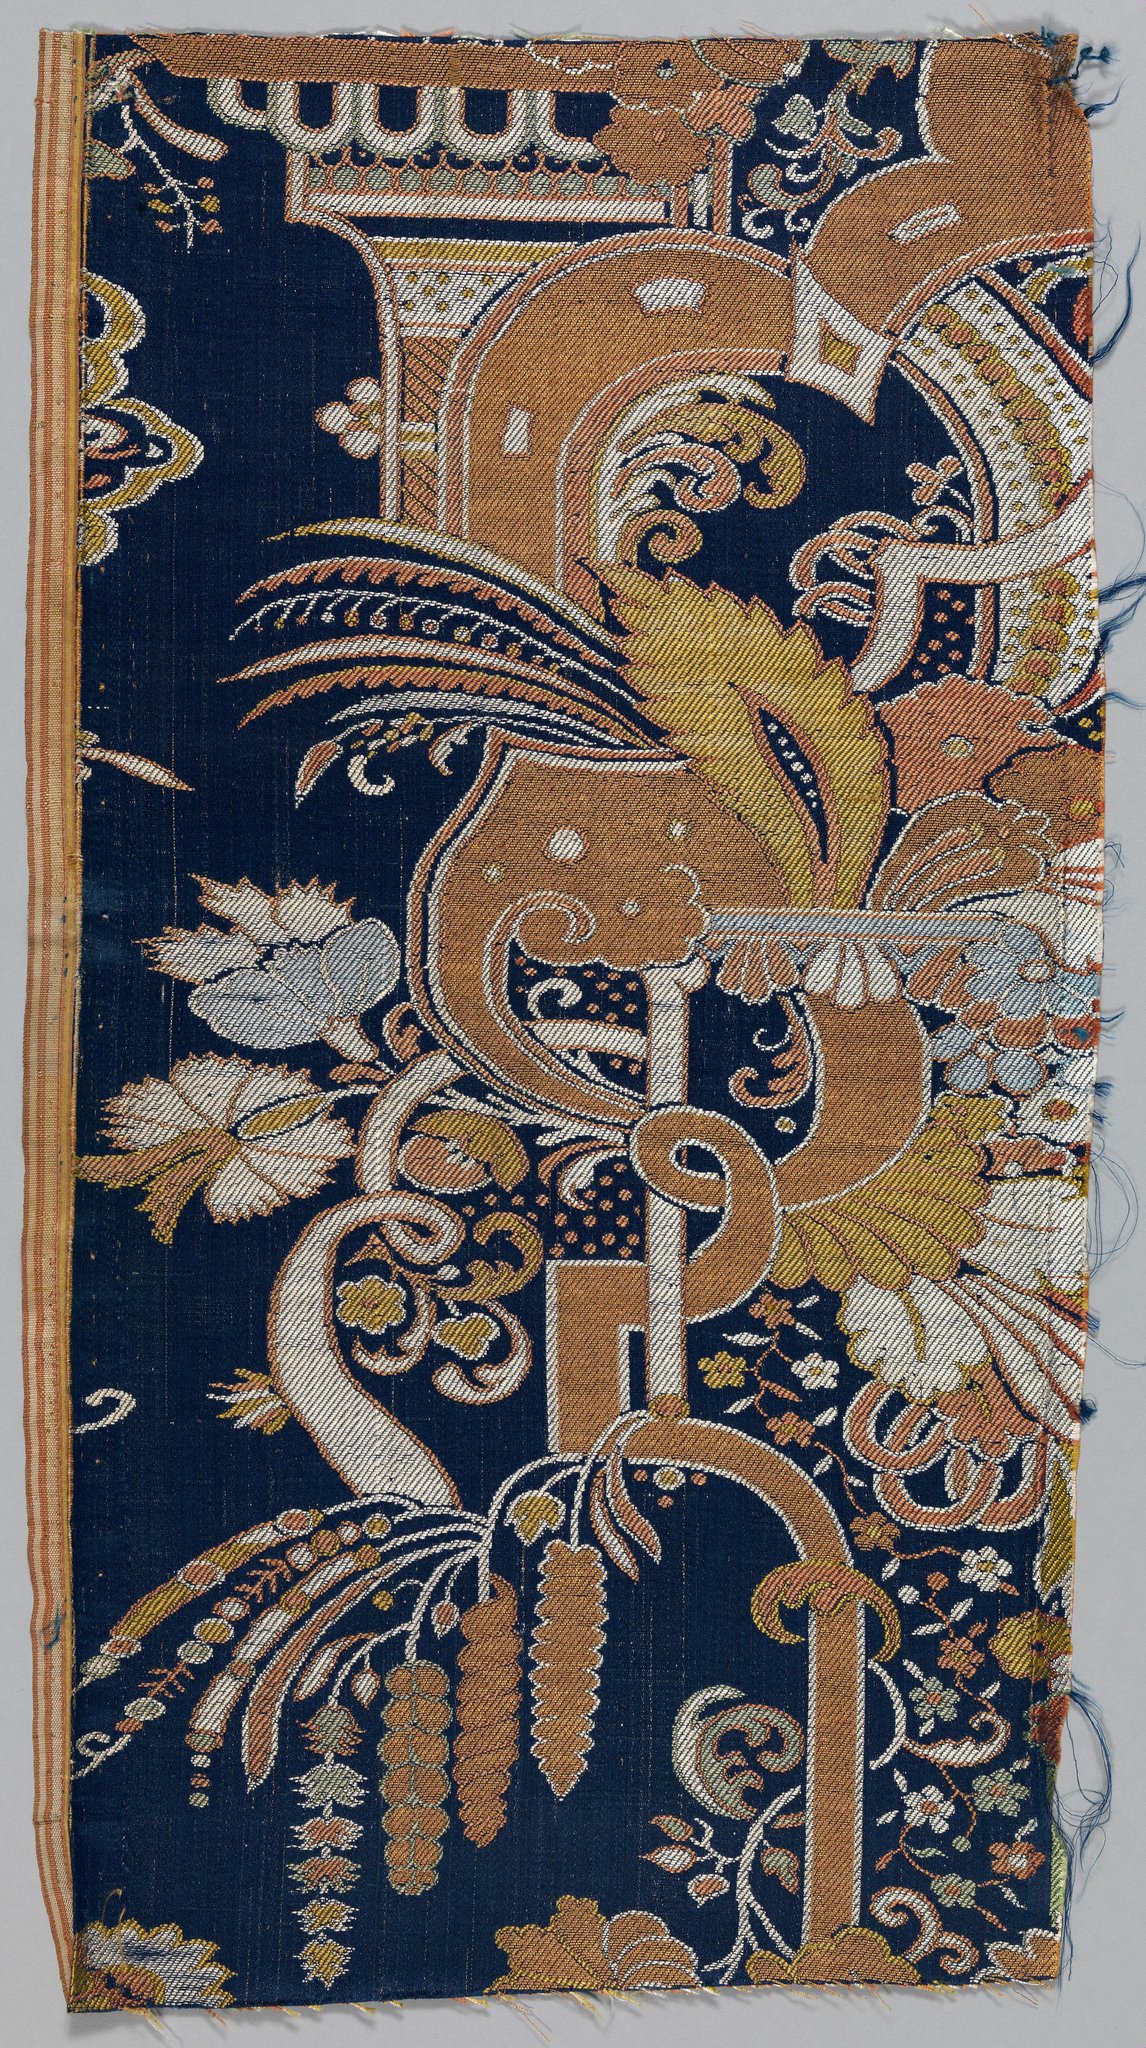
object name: fragment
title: Fragment of woven silk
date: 1701-1733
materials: metal thread, textile, silk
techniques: weave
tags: flowers,leaves